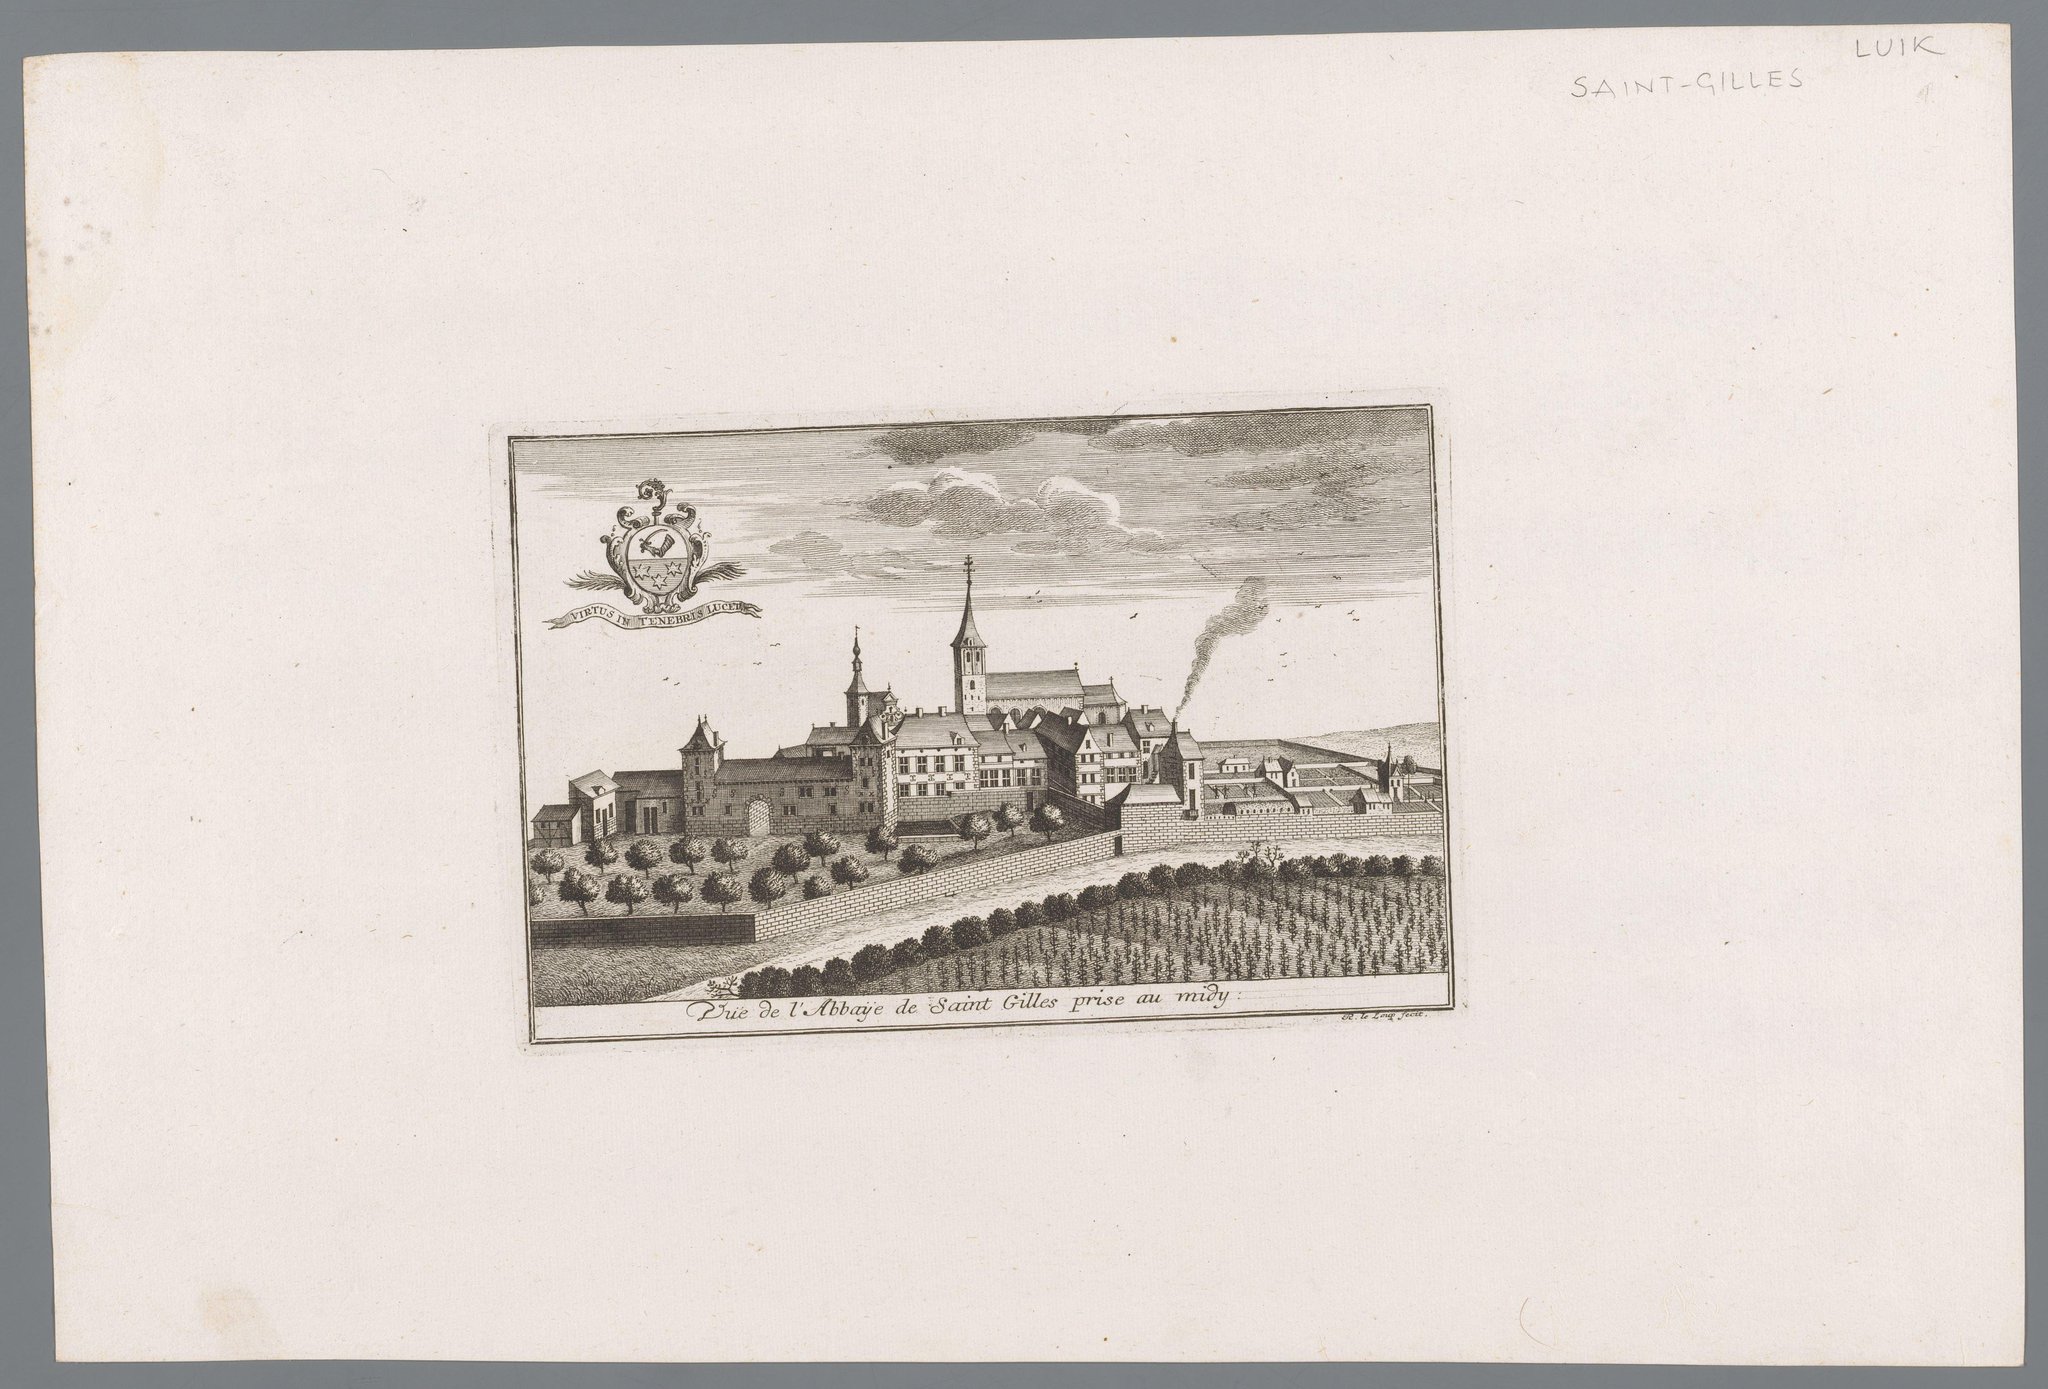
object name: print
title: Vue de l'Abbaye de Saint Gilles proche de Liege prise au midy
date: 1738-1744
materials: paper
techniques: engraving, etching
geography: liège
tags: abbey, monastery, convent ~ roman catholic church, liège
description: Prent uit: Johanne de Saumery, Alexandre de et al. Les délices du païs de Liège, ou description géographique, topographique et chorographique des monumes sacrés et profanes (...). 5 dln. Luik: Everard Kints, 1738-1744, dl. 1, p. 312.